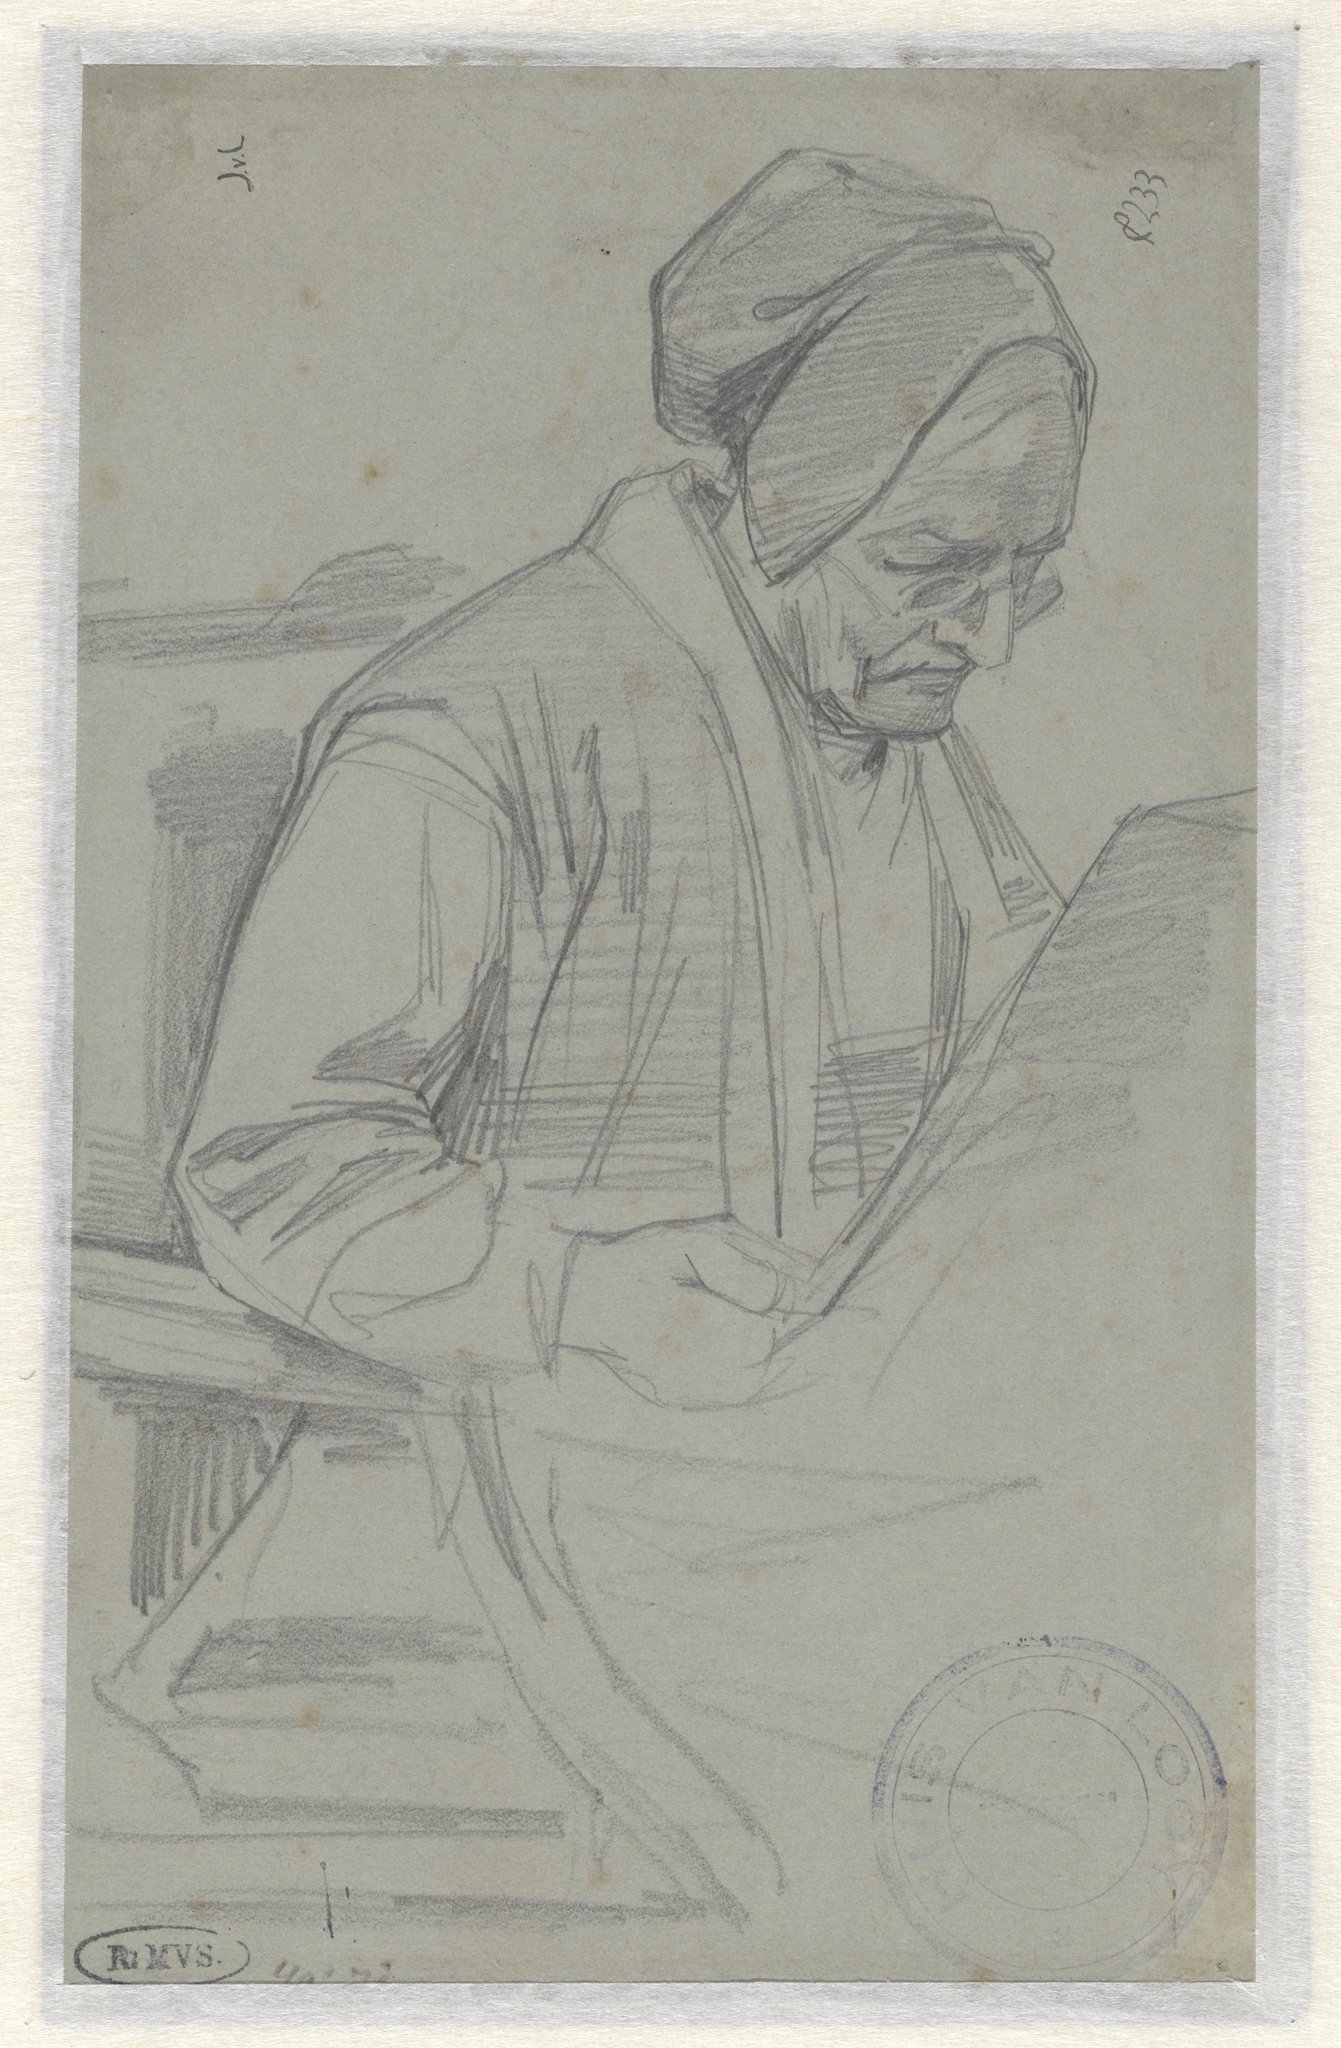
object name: drawing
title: Zittende lezende oude vrouw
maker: jac van looij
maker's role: draughtsman, painter, print maker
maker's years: 1855-1930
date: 1865-1930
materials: paper, pencil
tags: reading